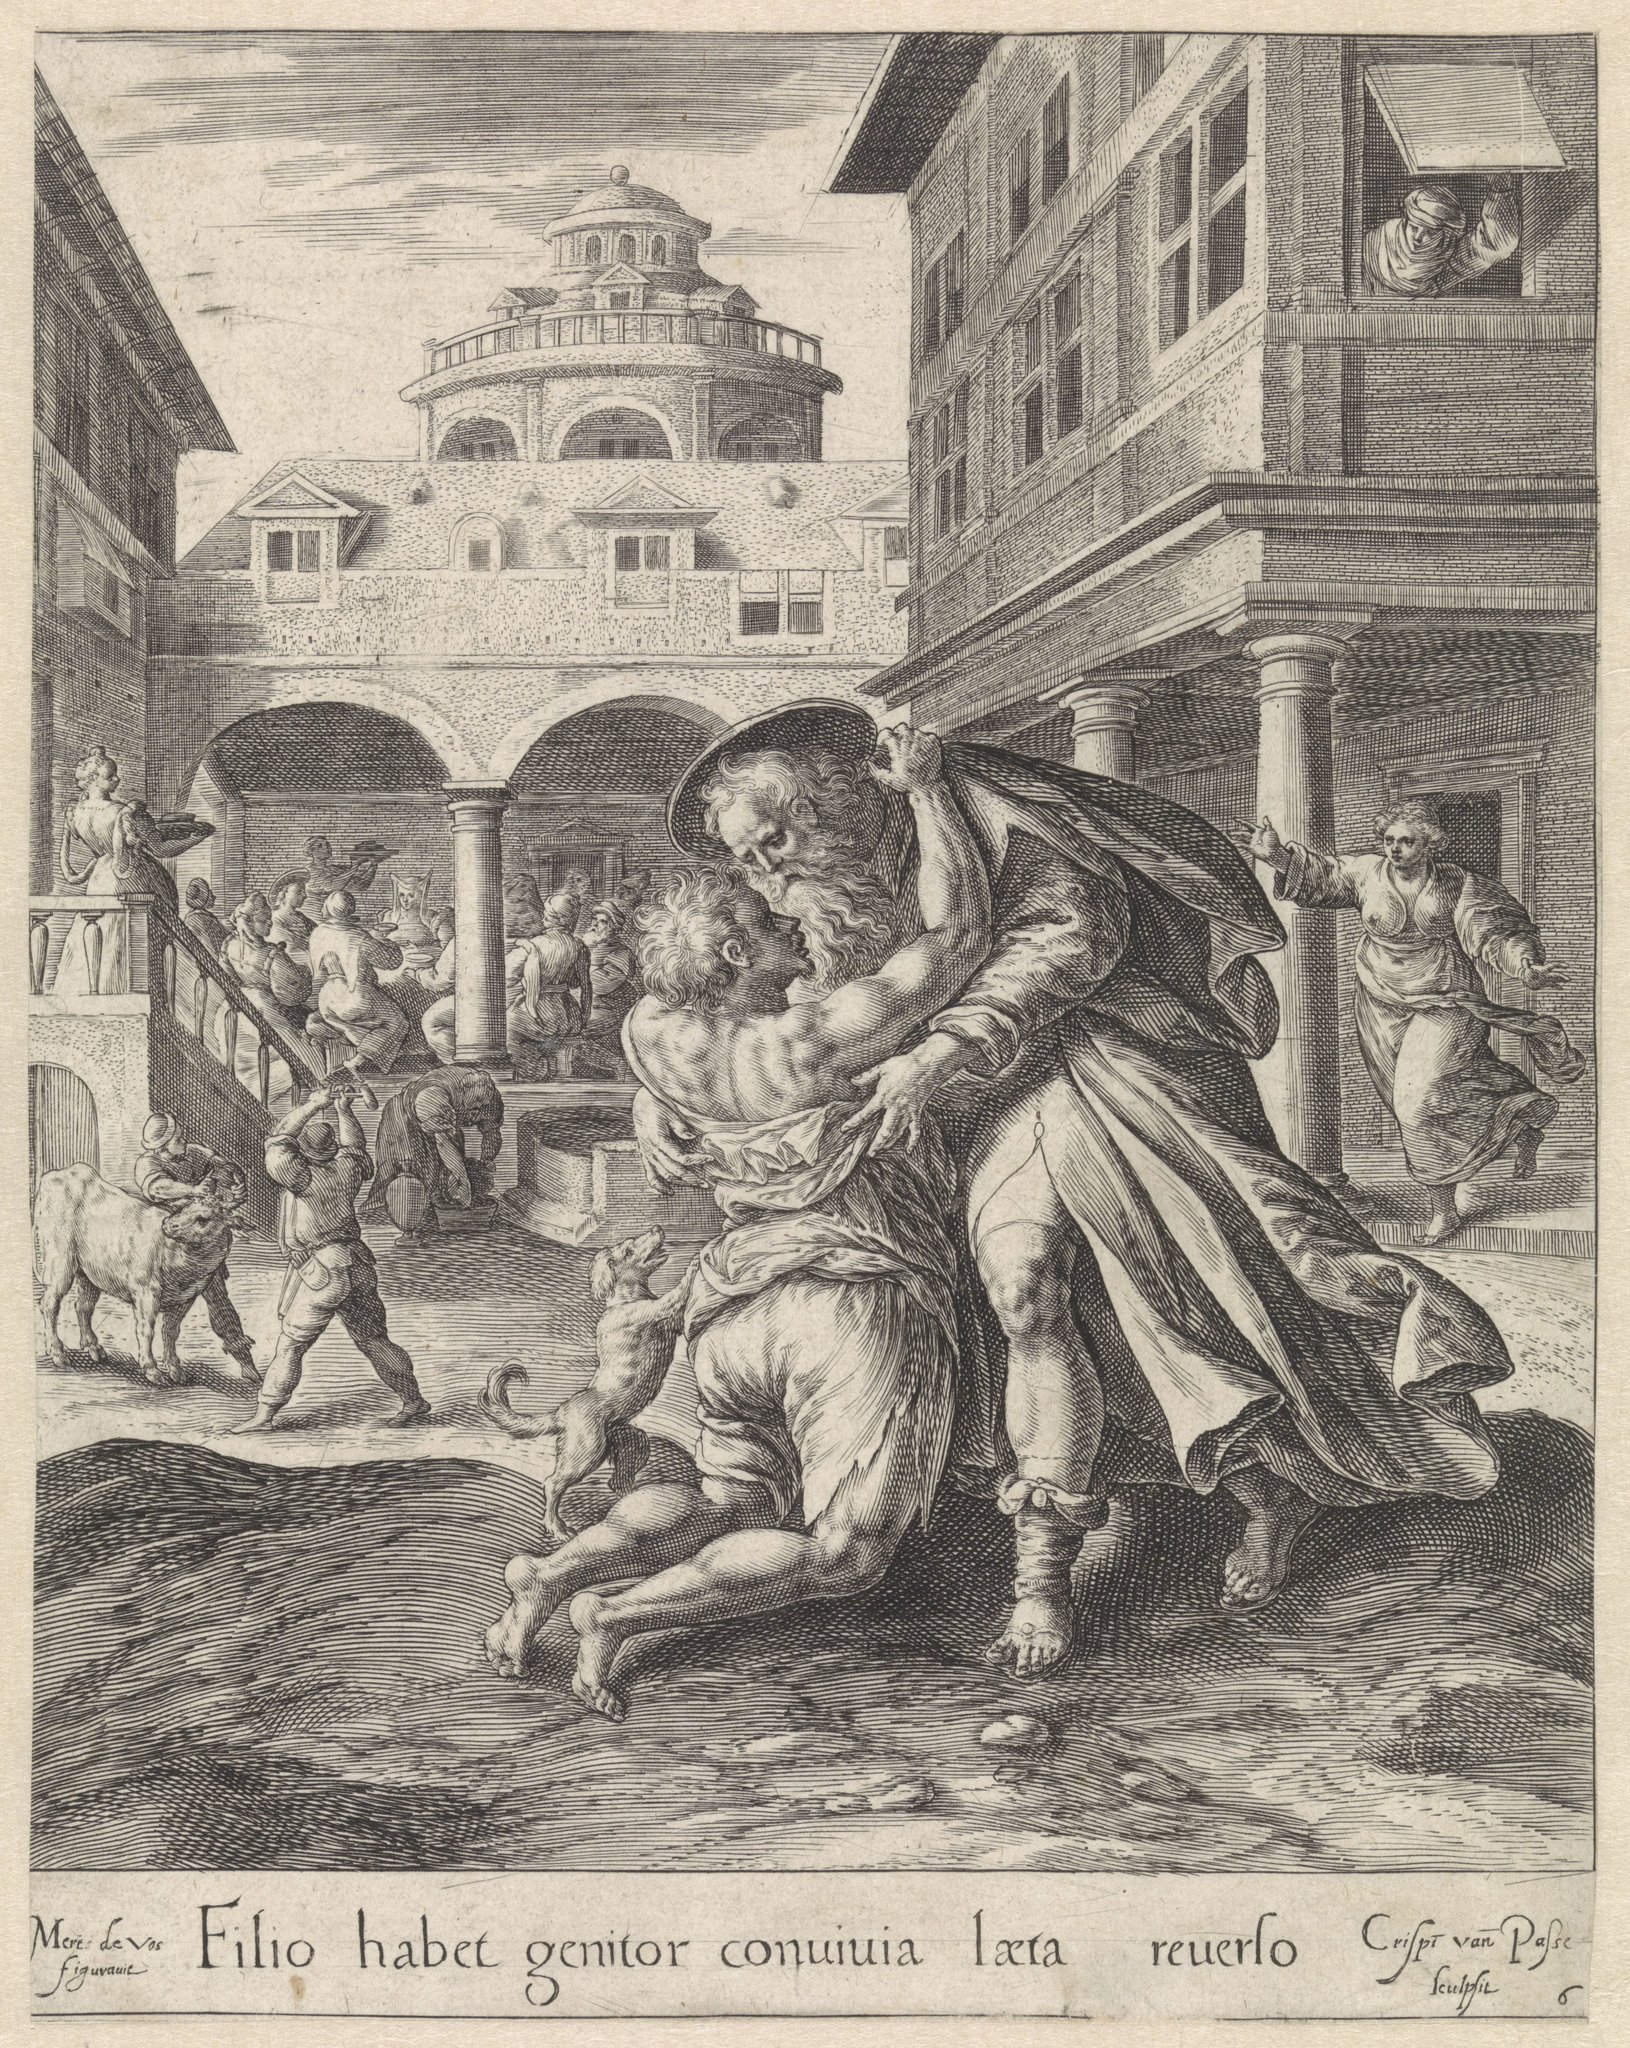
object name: print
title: Thuiskomst van de verloren zoon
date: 1580-1588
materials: paper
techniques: engraving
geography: antwerp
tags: festive reception of the prodigal son, the prodigal son returns home, where his father awaits him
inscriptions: collector's mark: Lugt 2228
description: De verloren zoon keert terug naar huis. Hij wordt daar opgewacht door zijn vader, die hem hartelijk verwelkomt. Hij laat een kalf slachten voor een feestmaal om de terugkeer van zijn zoon te vieren. In de marge een onderschrift in het Latijn.